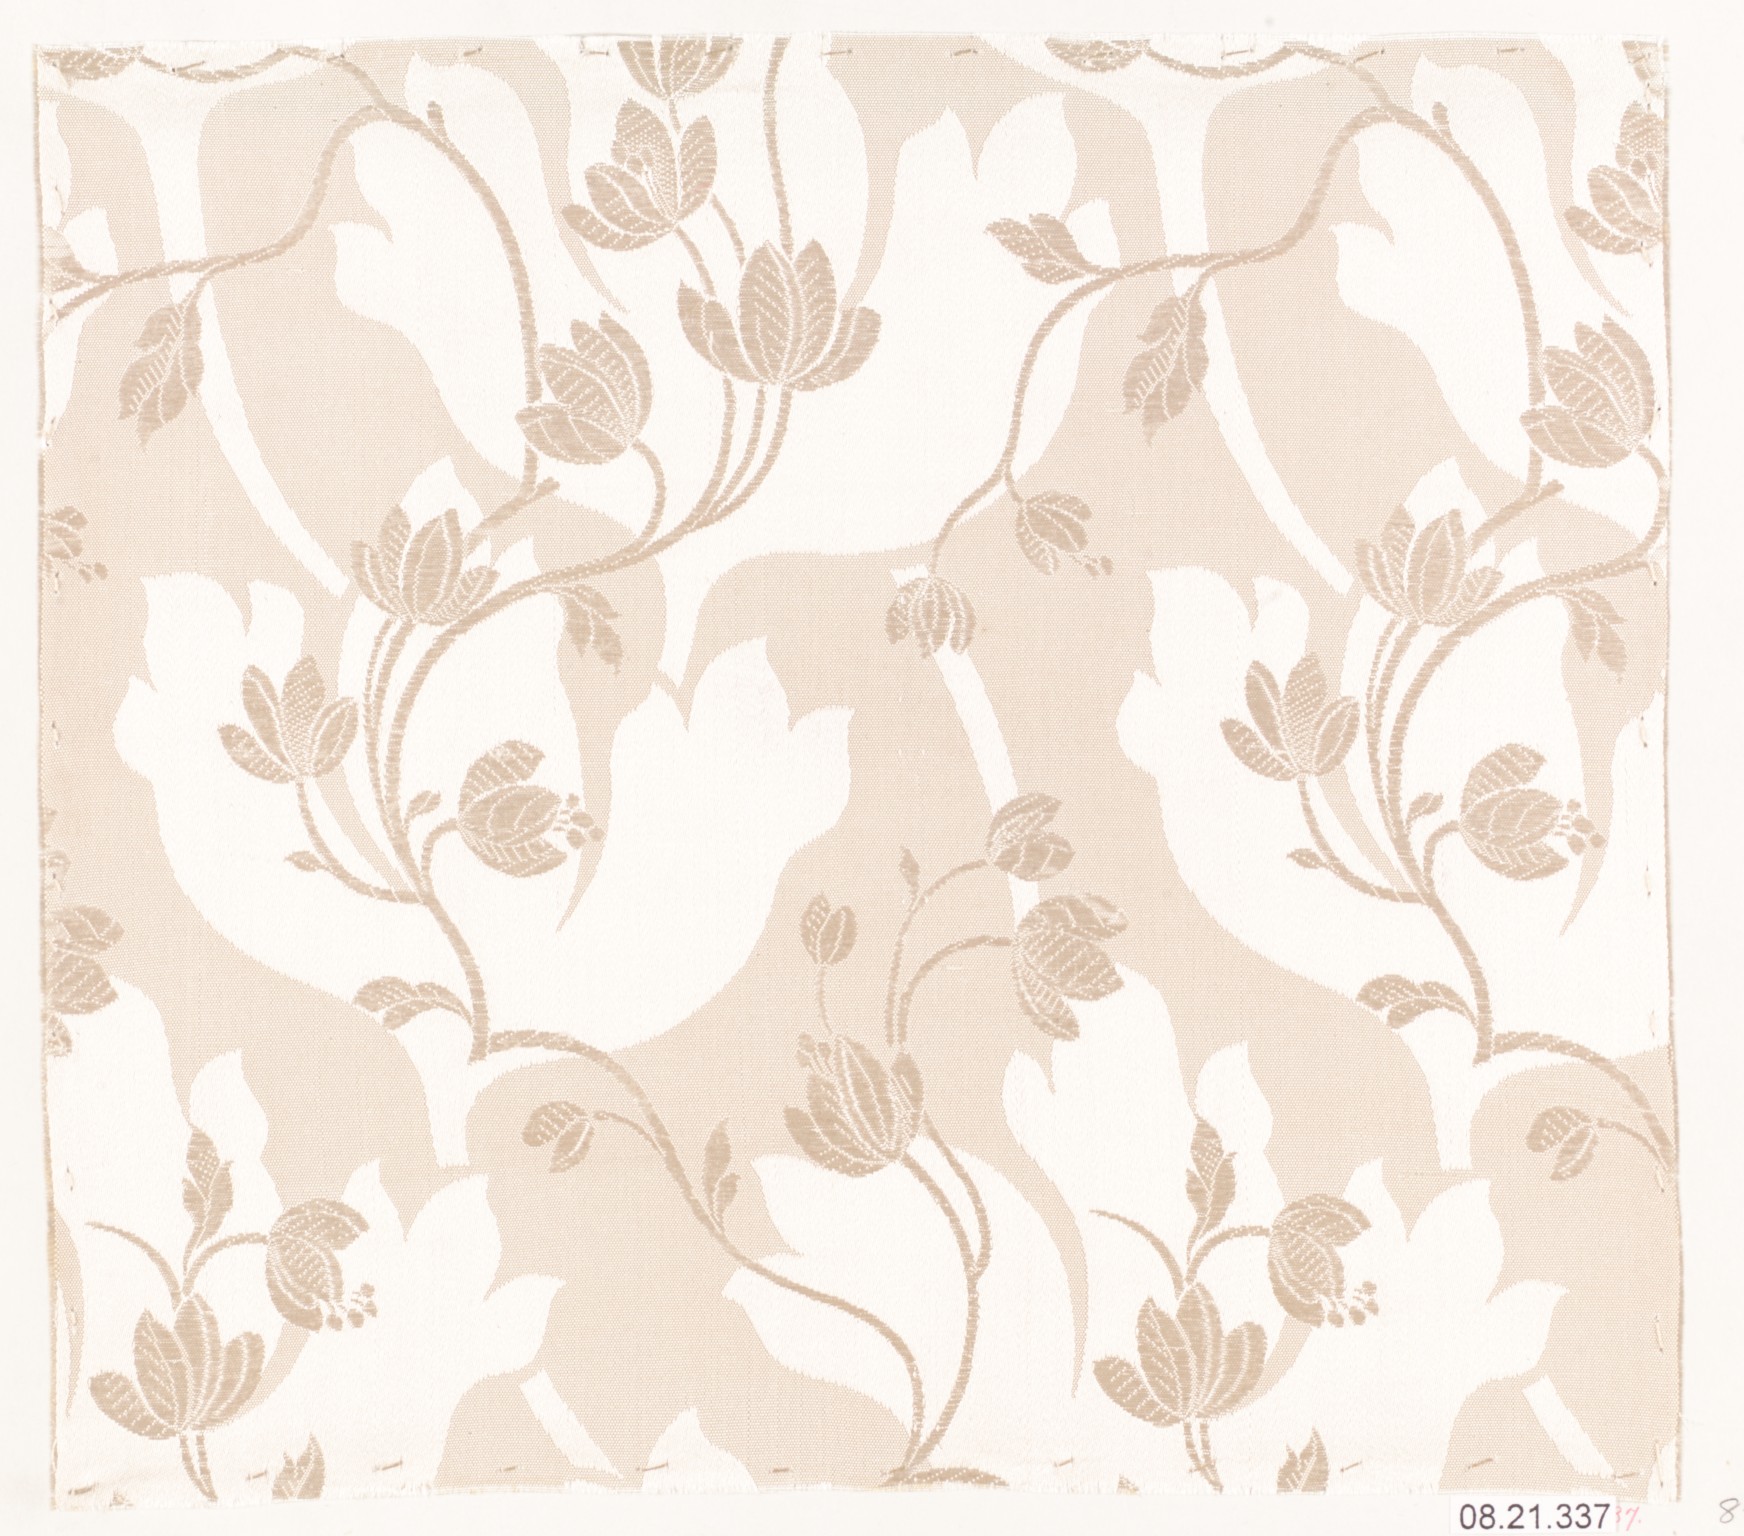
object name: textile sample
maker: Anonymous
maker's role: designer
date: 1900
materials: silk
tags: flowers